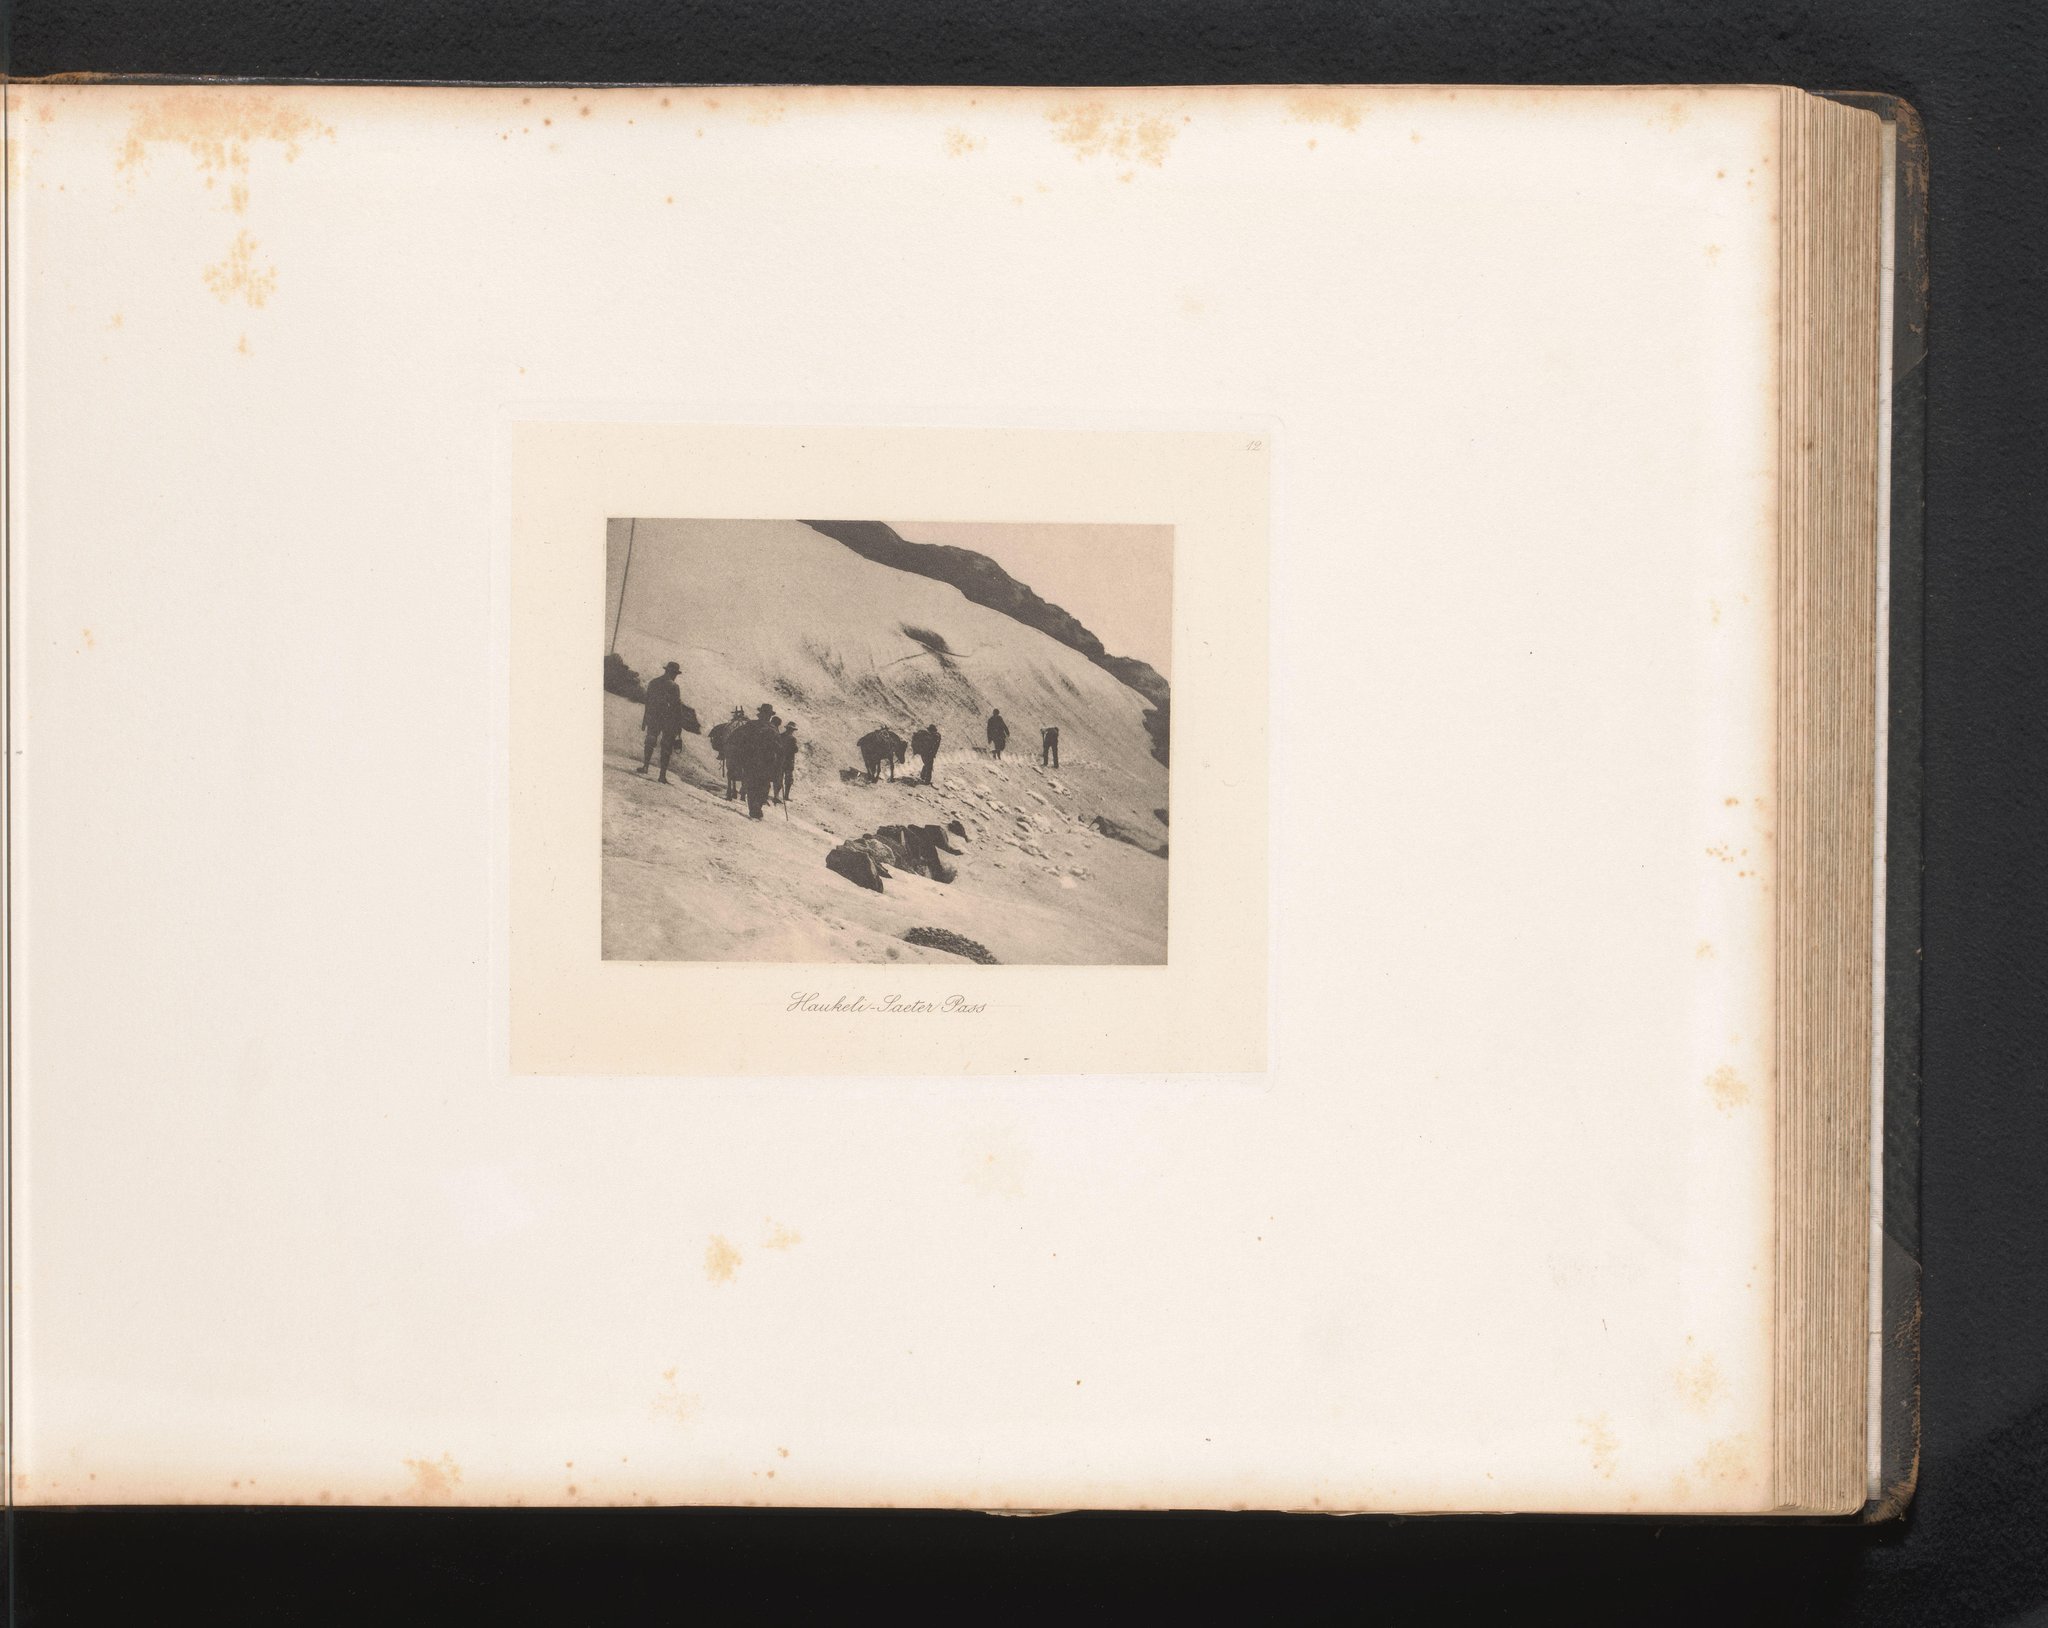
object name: photomechanical print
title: Oversteek van de Haukeliseterpas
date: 1888-1893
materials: paper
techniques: photograph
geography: vienna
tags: mountain climbing, mountaineering, mountain-range, snow peaks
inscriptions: number: ‘12’